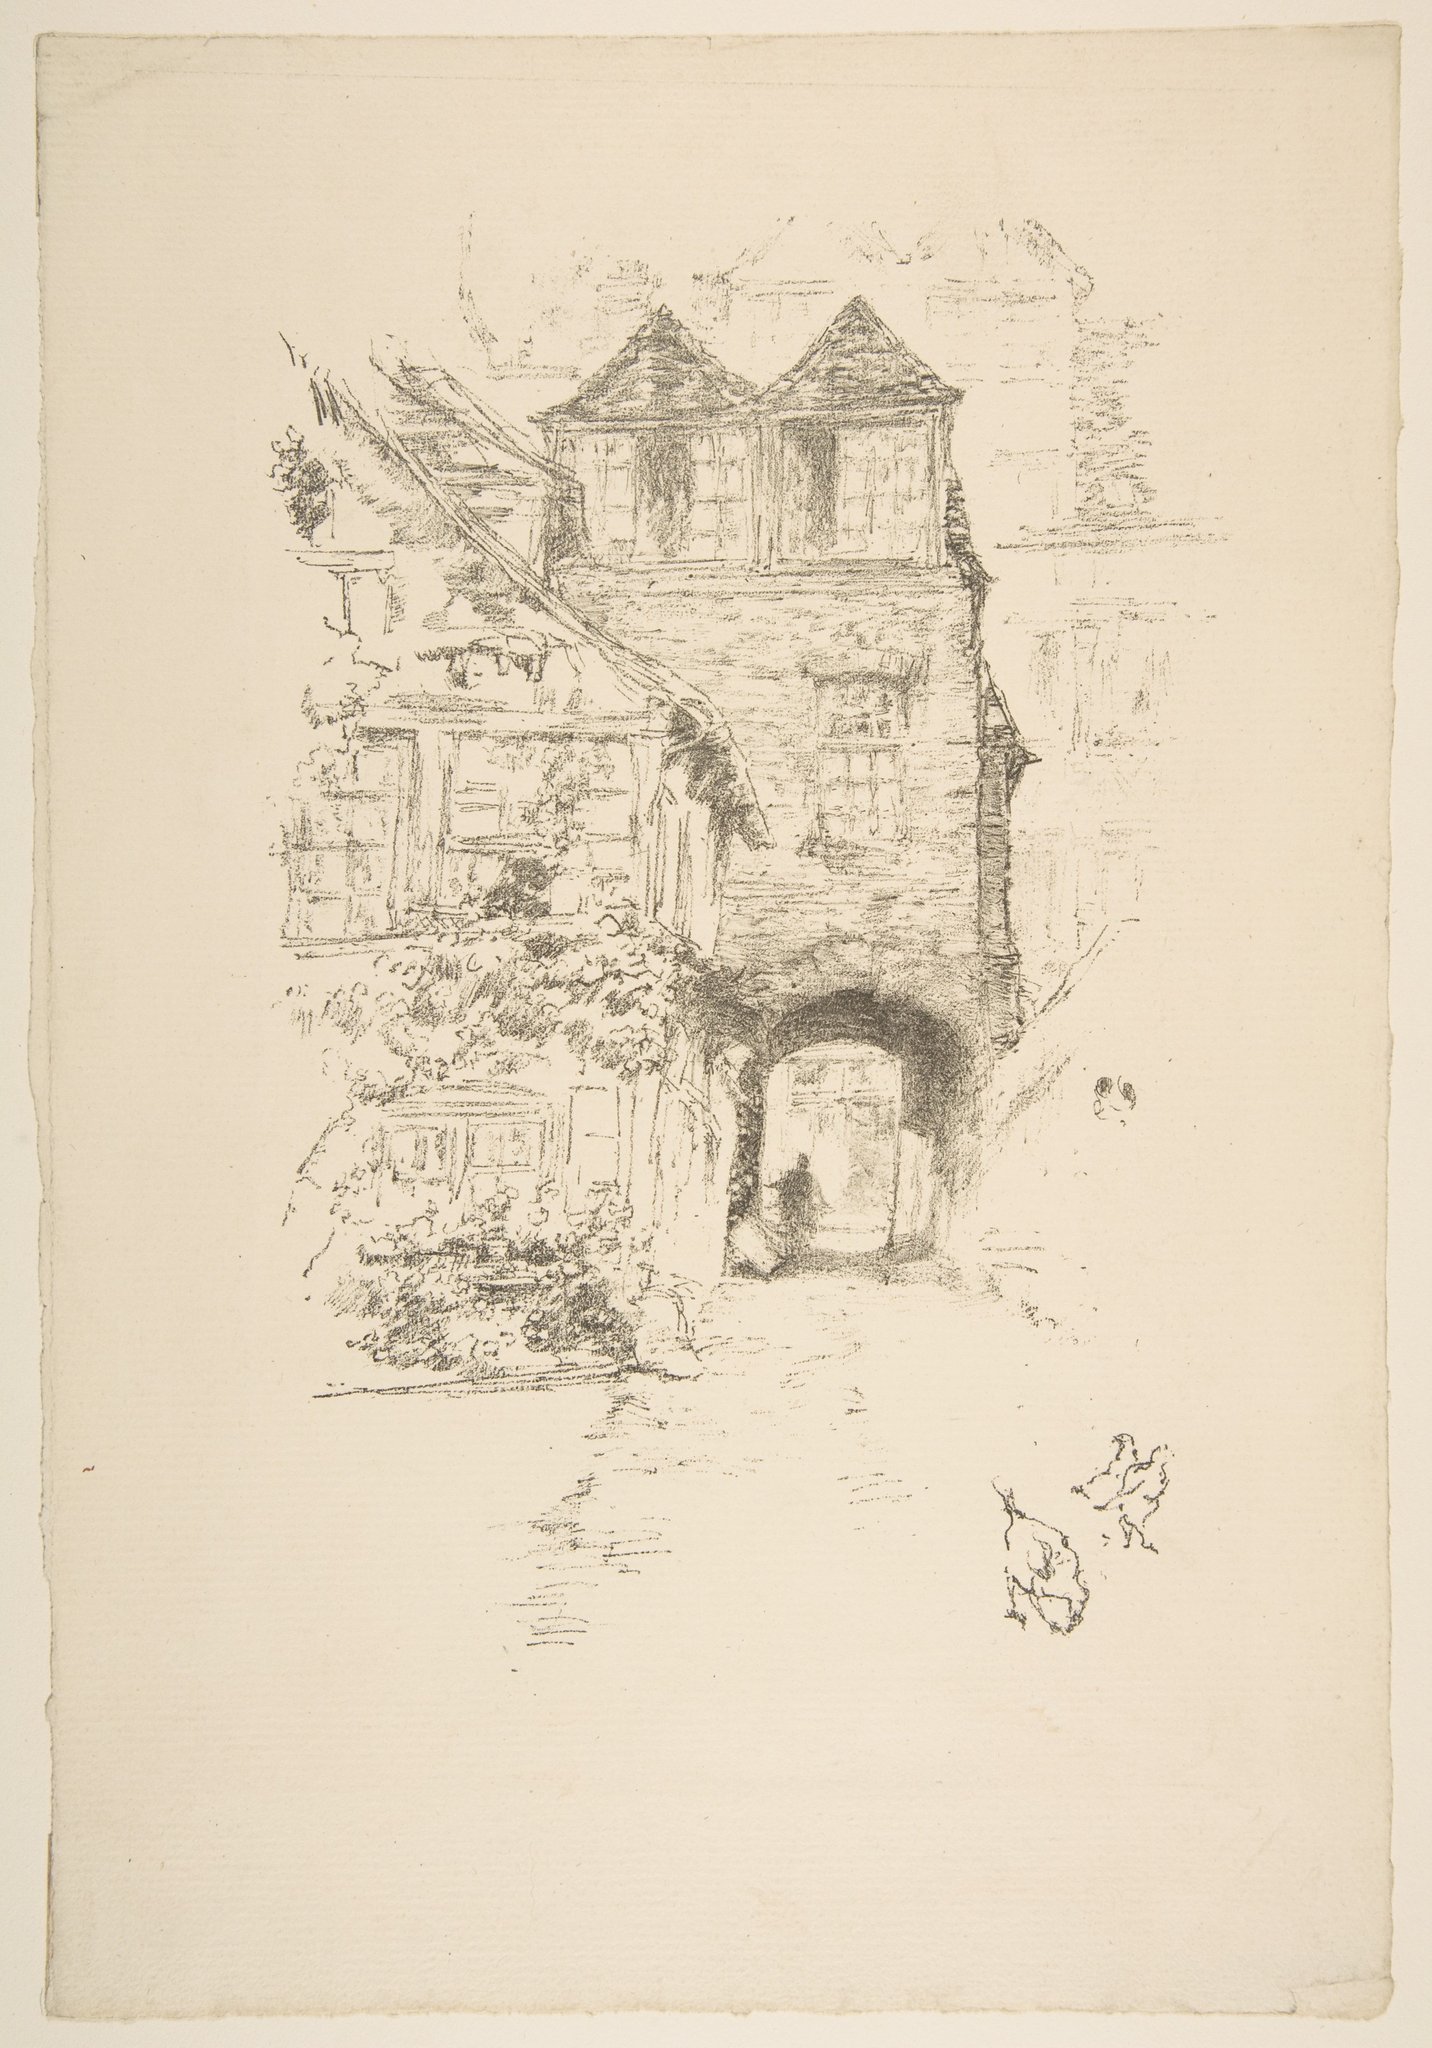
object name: print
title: The Priest's House, Rouen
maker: james mcneill whistler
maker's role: artist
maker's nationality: american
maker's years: 1834-1903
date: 1894-1895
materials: ink, paper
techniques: printing, stumping, lithography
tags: buildings